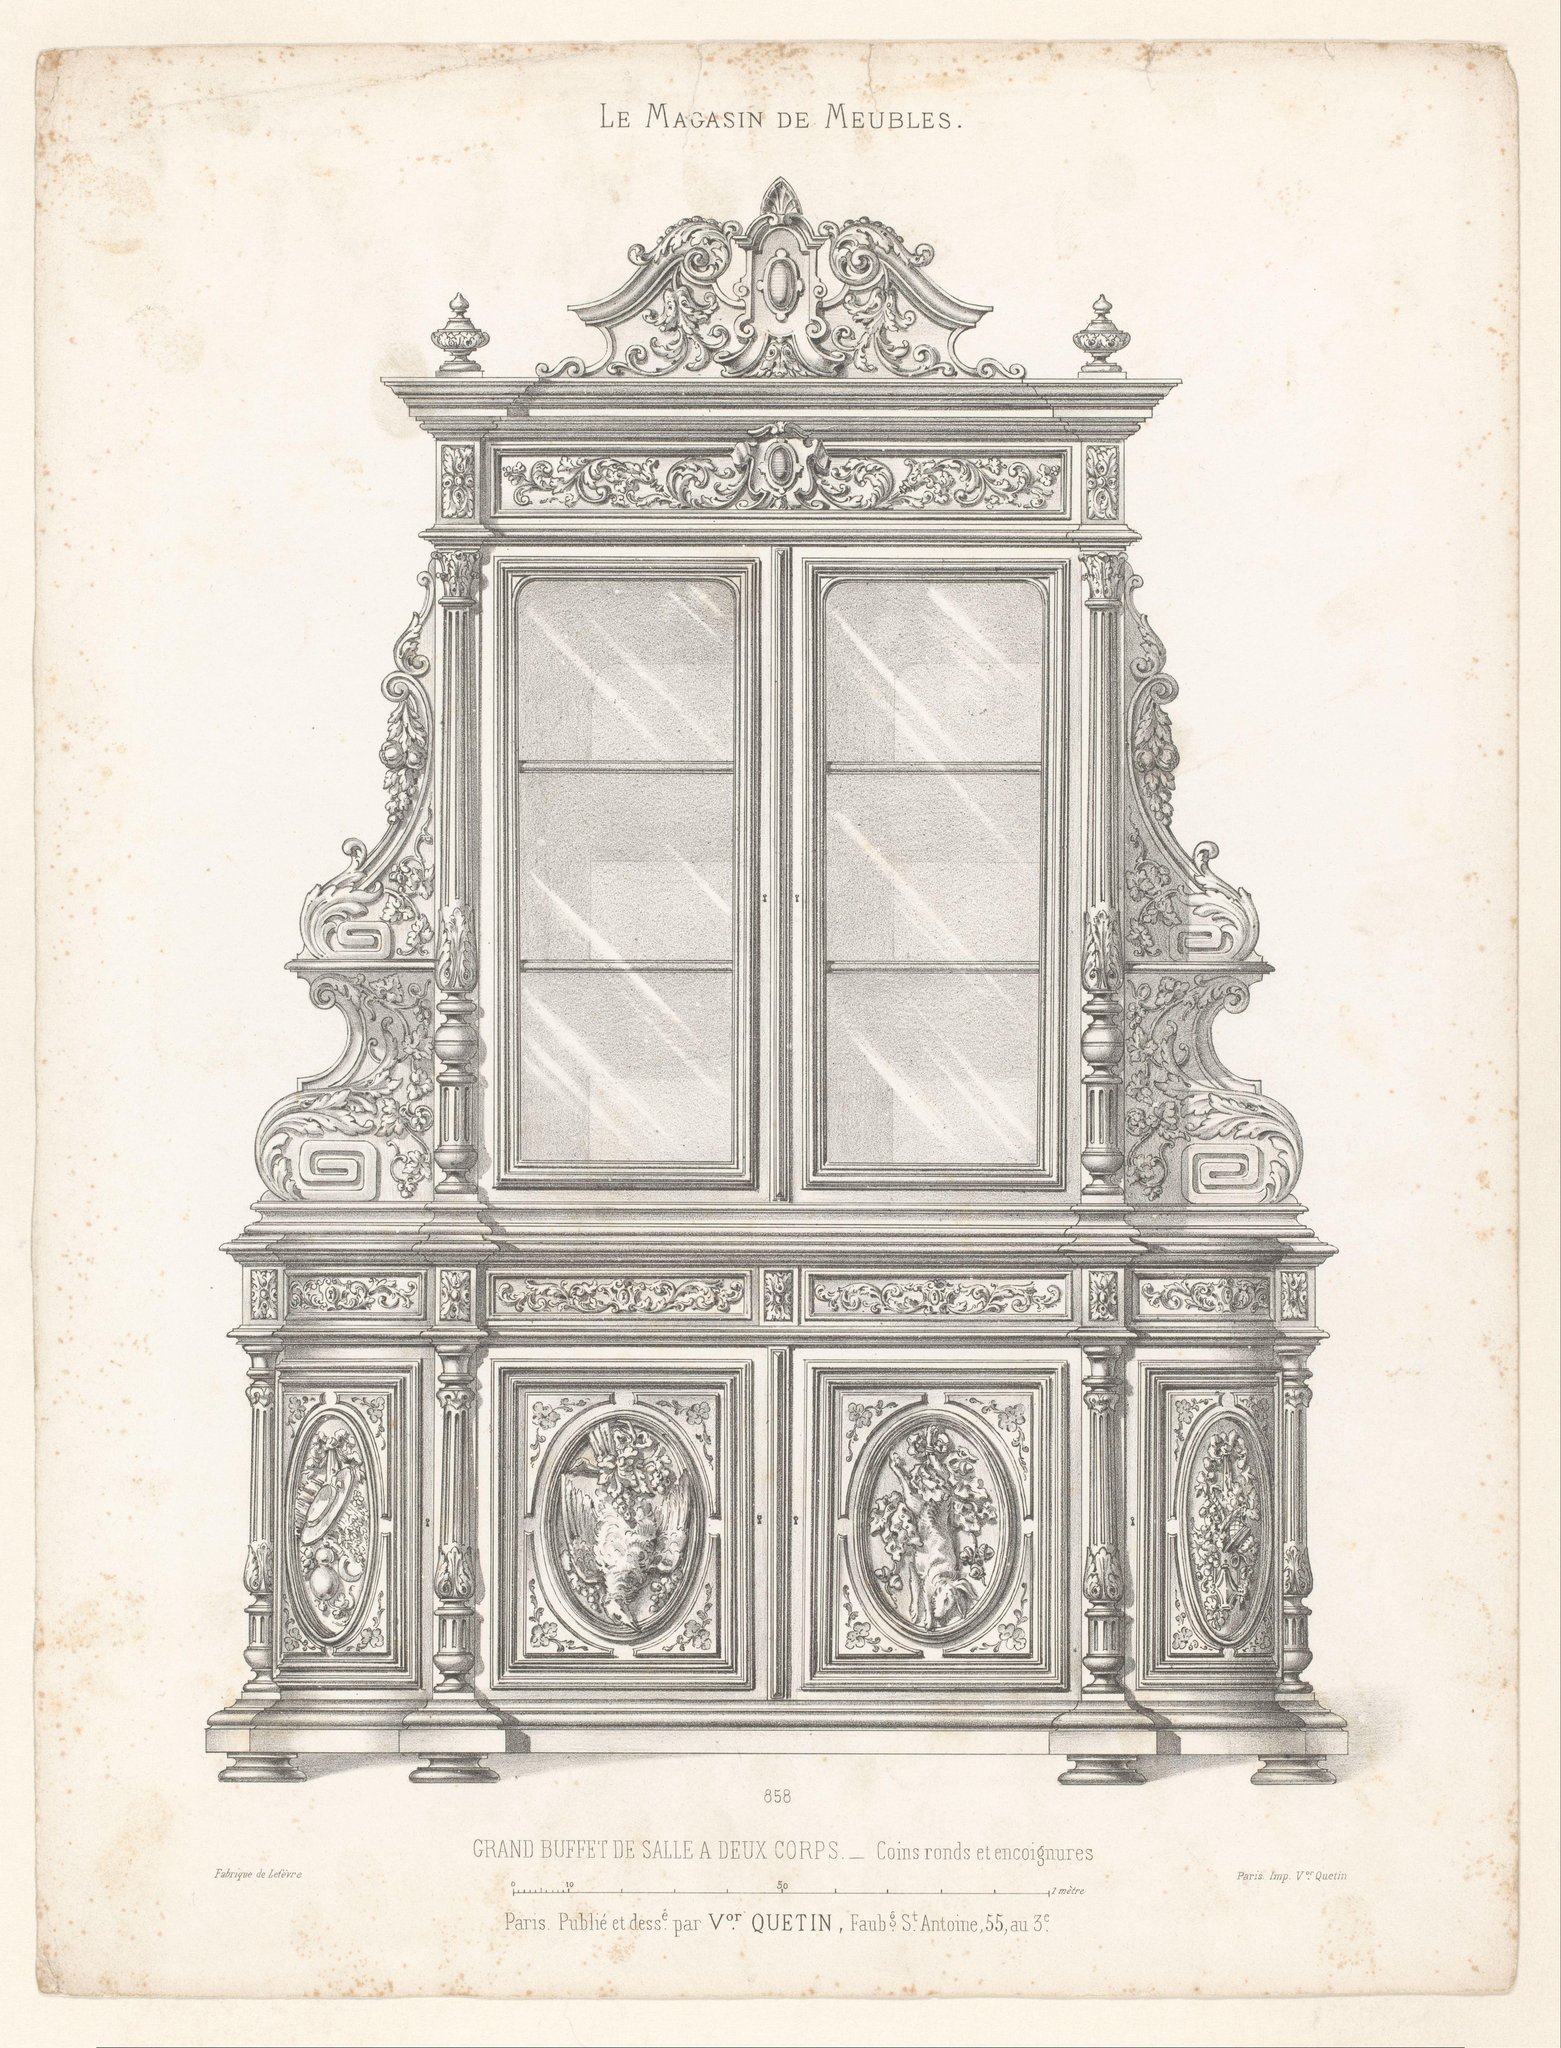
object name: print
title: Grand buffet de salle a deux corps Coins ronds et encoignures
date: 1832-1877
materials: paper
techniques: lithograph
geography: paris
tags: furniture for storage